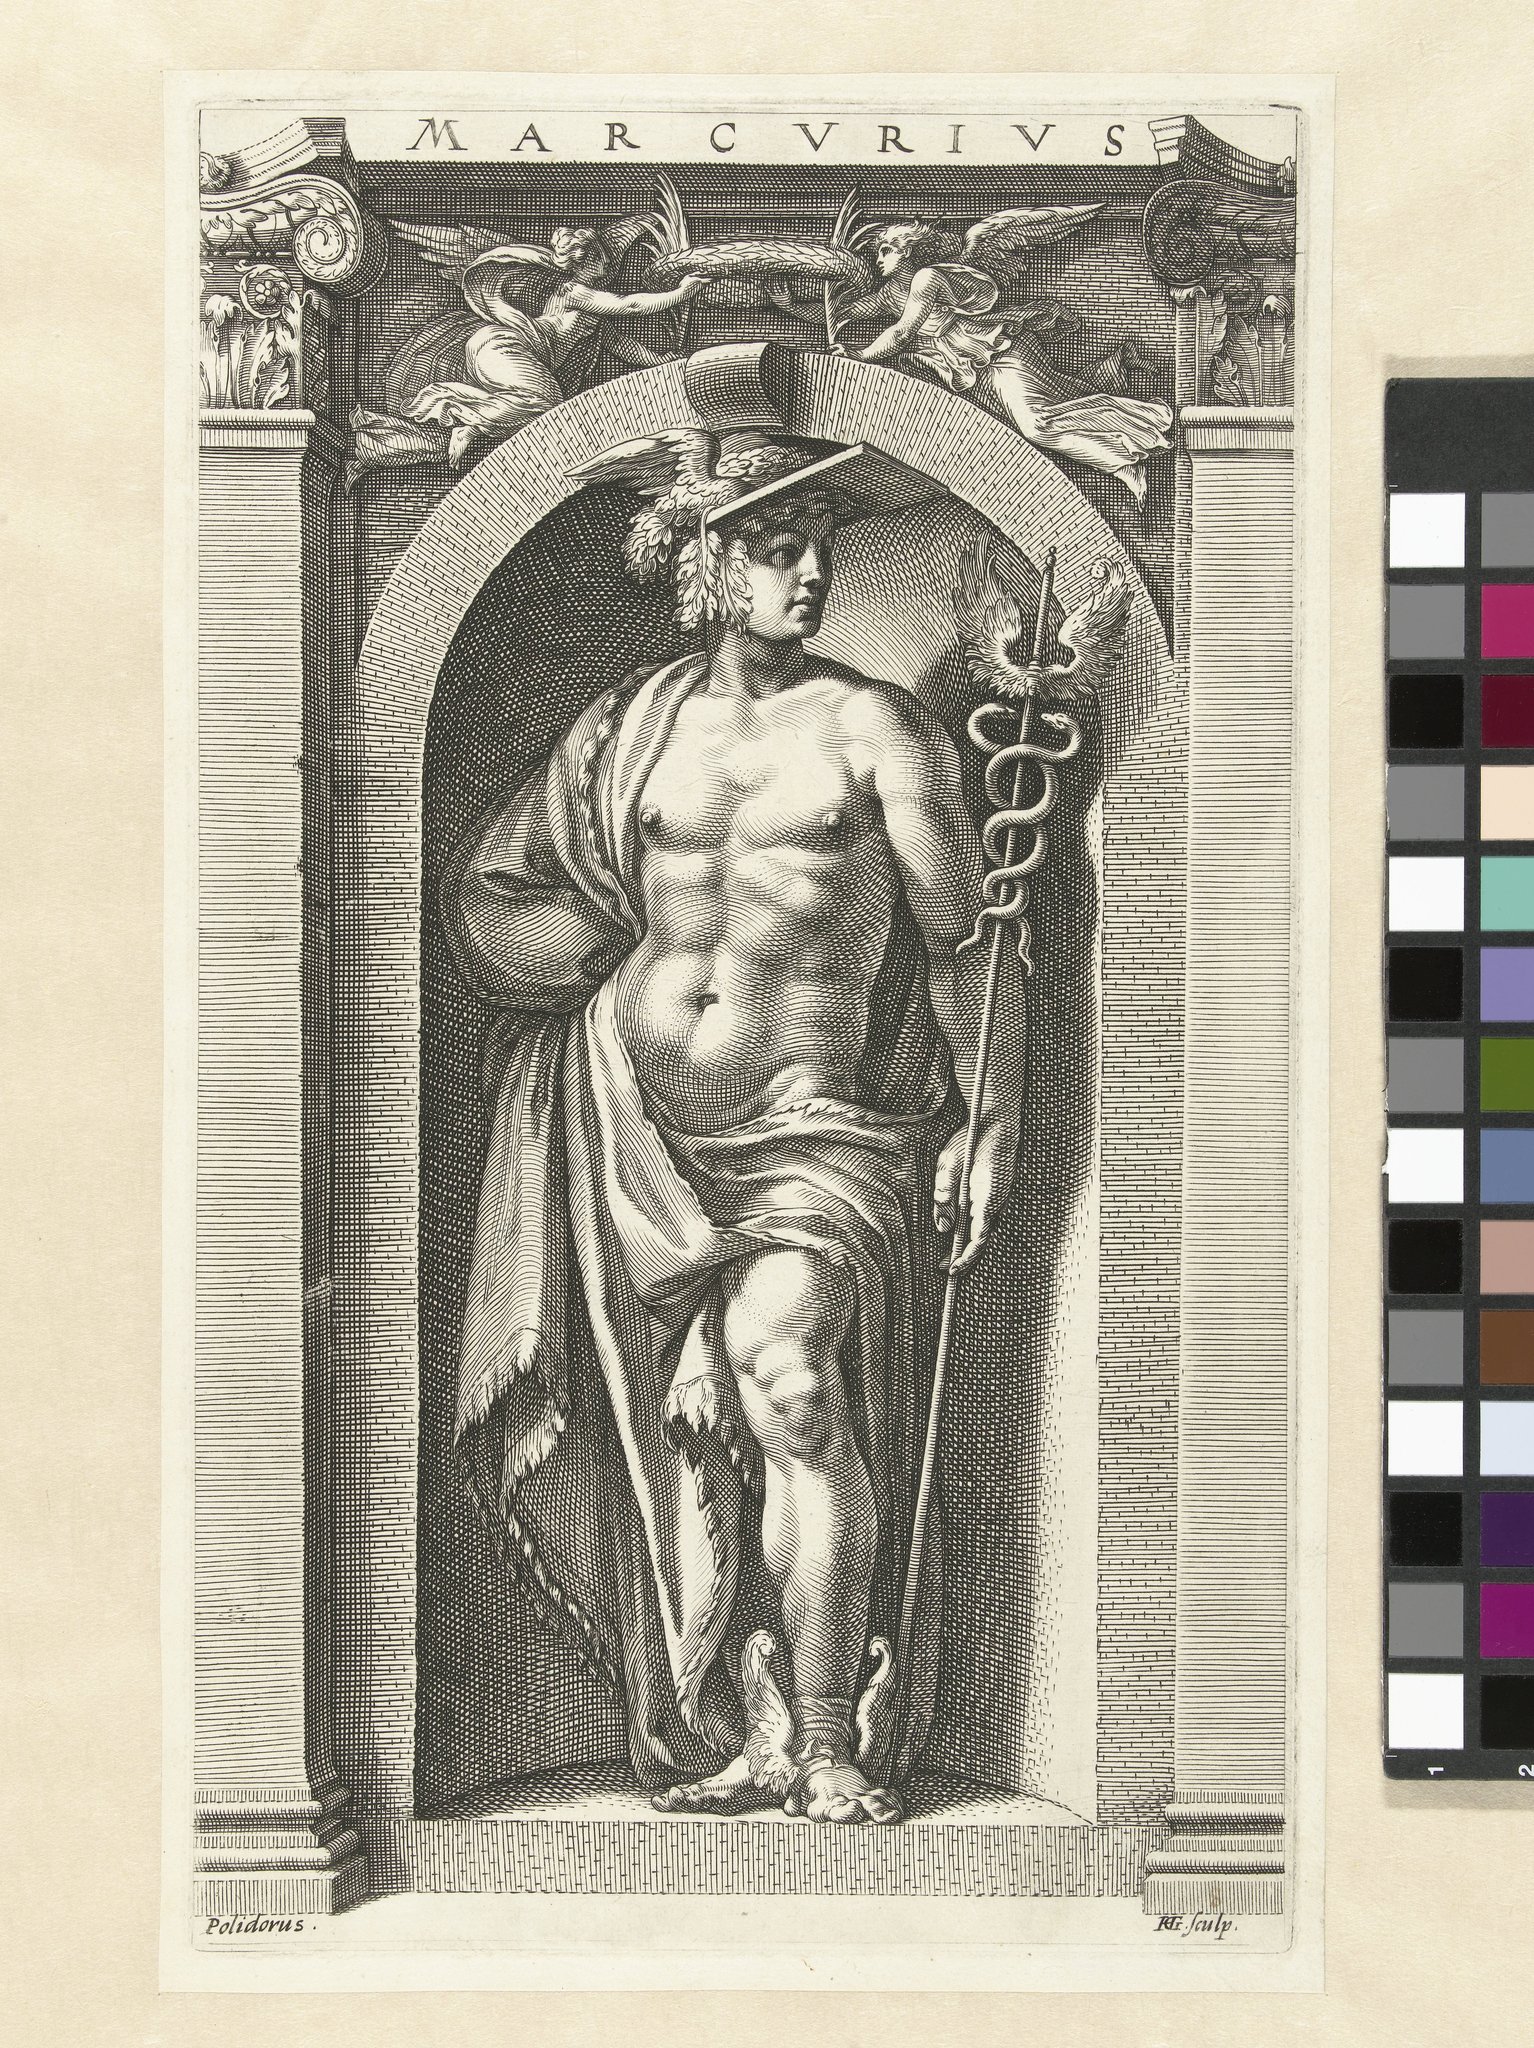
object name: print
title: Marcurius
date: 1592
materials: paper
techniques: engraving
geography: haarlem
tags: (story of) mercury (hermes)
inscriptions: collector's mark: Lugt 240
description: Mercurius, staand in een nis, een caduceus in zijn linkerhand, een gevleugelde pet op zijn hoofd en gevleugelde schoenen aan zijn voeten. Deze prent is onderdeel van een serie van acht prenten van klassieke goden, gebaseerd op schilderingen van Polidoro da Caravaggio op de façade van een Romeins huis, door Goltzius in Rome gezien en nagetekend.